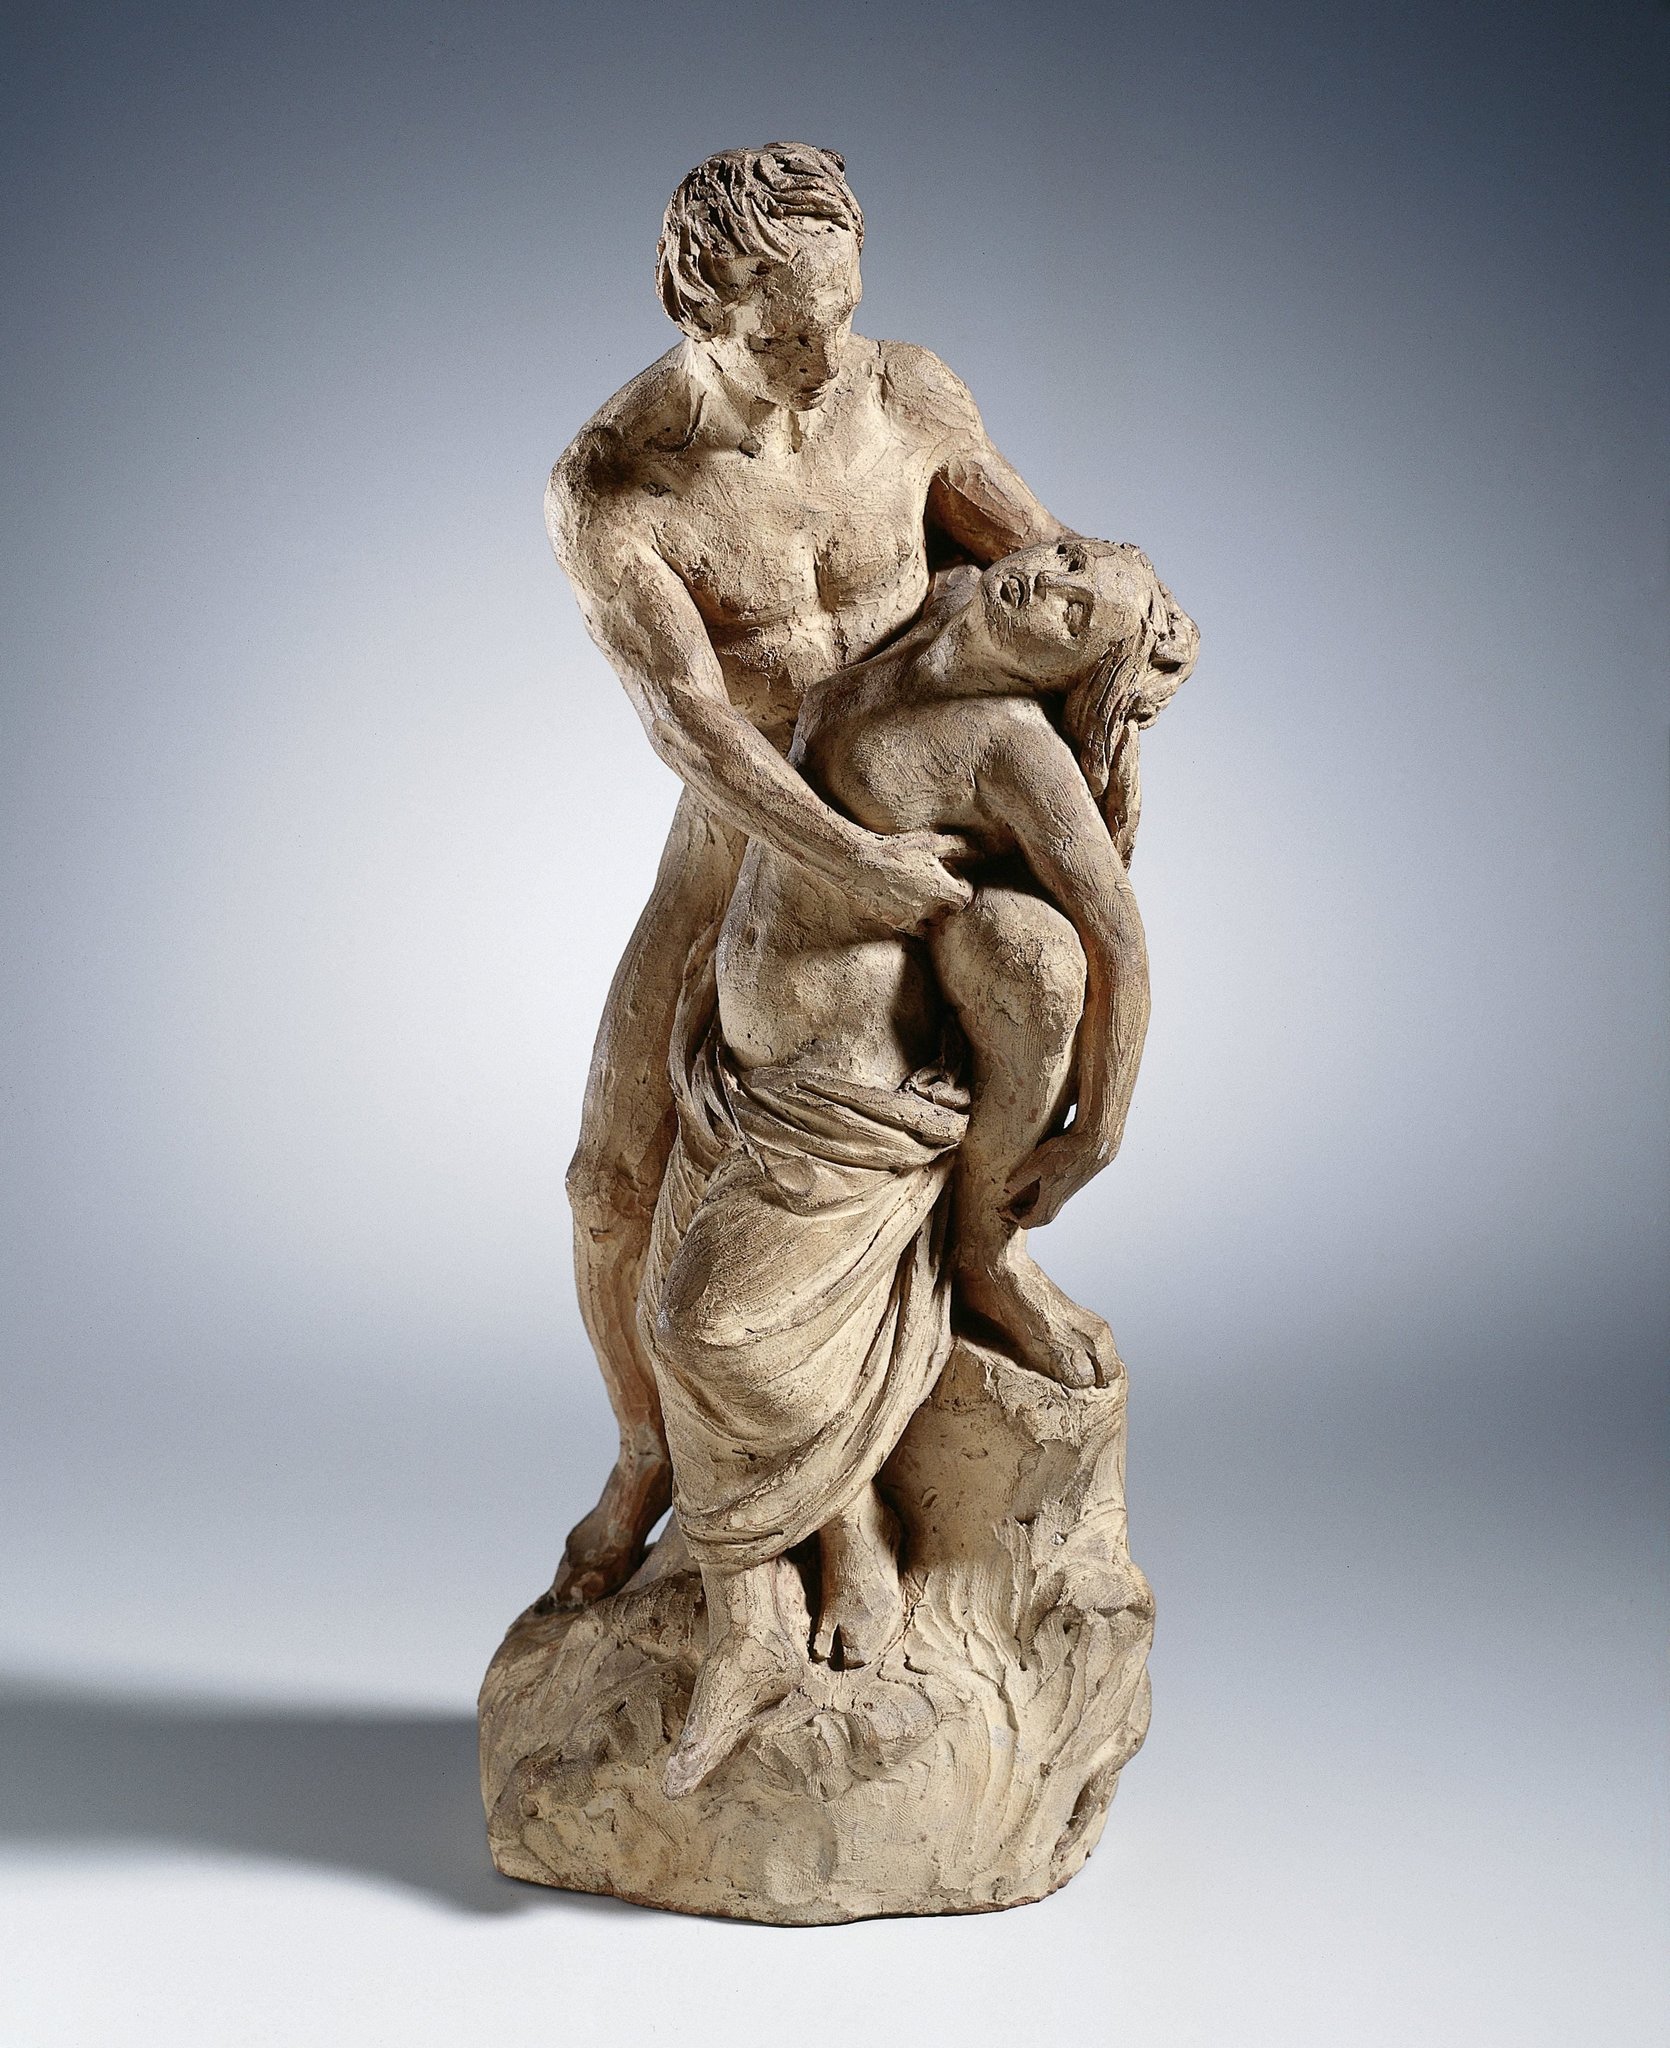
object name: sculpture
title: Scene uit de zondvloed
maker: louis royer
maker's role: draughtsman, sculptor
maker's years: 1793-1868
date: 1833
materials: terracotta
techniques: molding, painting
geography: netherlands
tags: the flood and destruction of mankind ~ story of noah (genesis 7:10 - 8:17)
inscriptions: signature: ‘L. ROYER’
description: Op een grondje staat een naakte jongeling op het rechterbeen en met het gebogen linker op een verhoging. Hij houdt met de rechterarm een tegen zijn gebogen knie slap achterover hangende vrouw vast, die haar linkerarm langs zijn knie laat vallen en haar rechter om zijn rug houdt; met de linkerhand ondersteunt hij haar hoofd. Haar kleed is tot het middel afgegleden, waardoor het bovenlichaam onbedekt is. Aan de achterzijde van het grondje een deel van een slang(?).